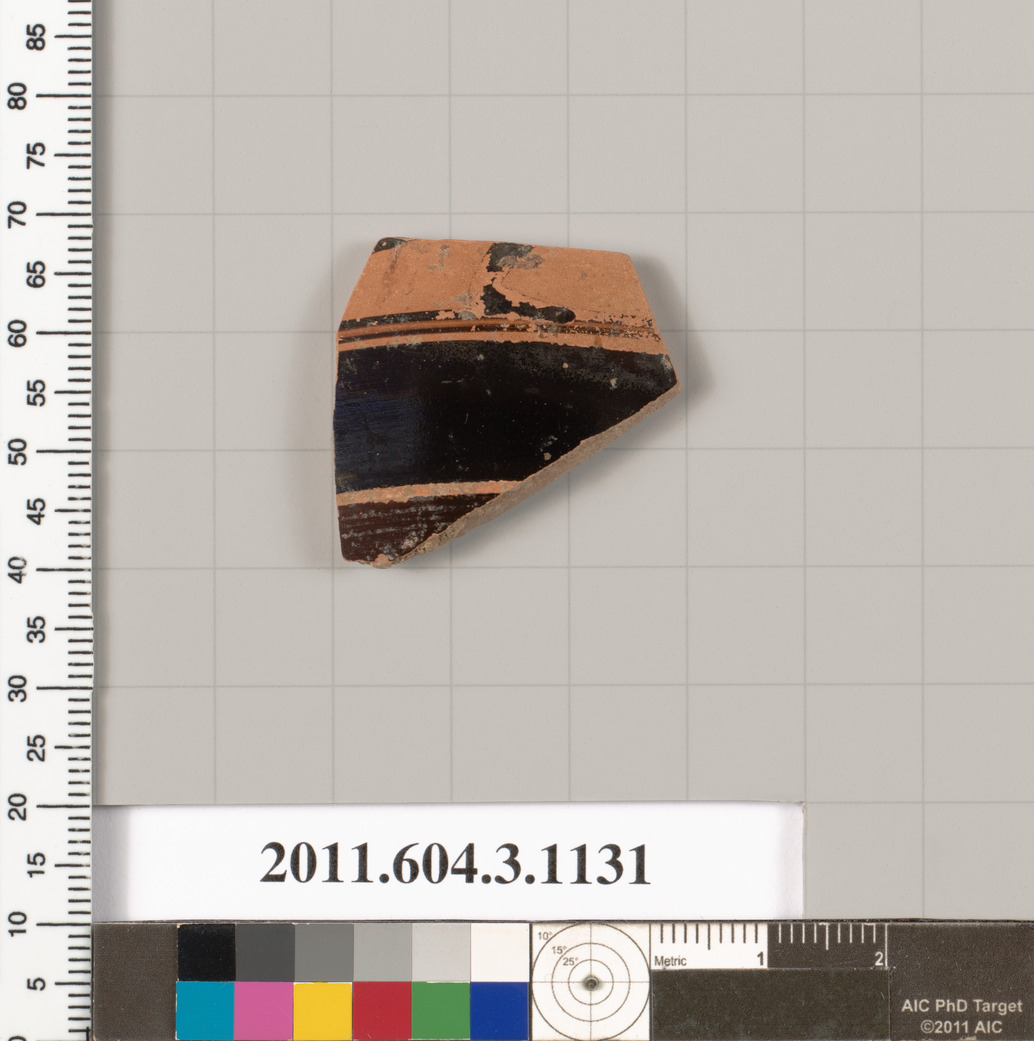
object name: mastoid or kyathos fragment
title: Terracotta fragment of a mastoid (drinking cup with narrow base) or a kyathos (cup-shaped ladle)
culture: greek, attic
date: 534-468 BCE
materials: terracotta